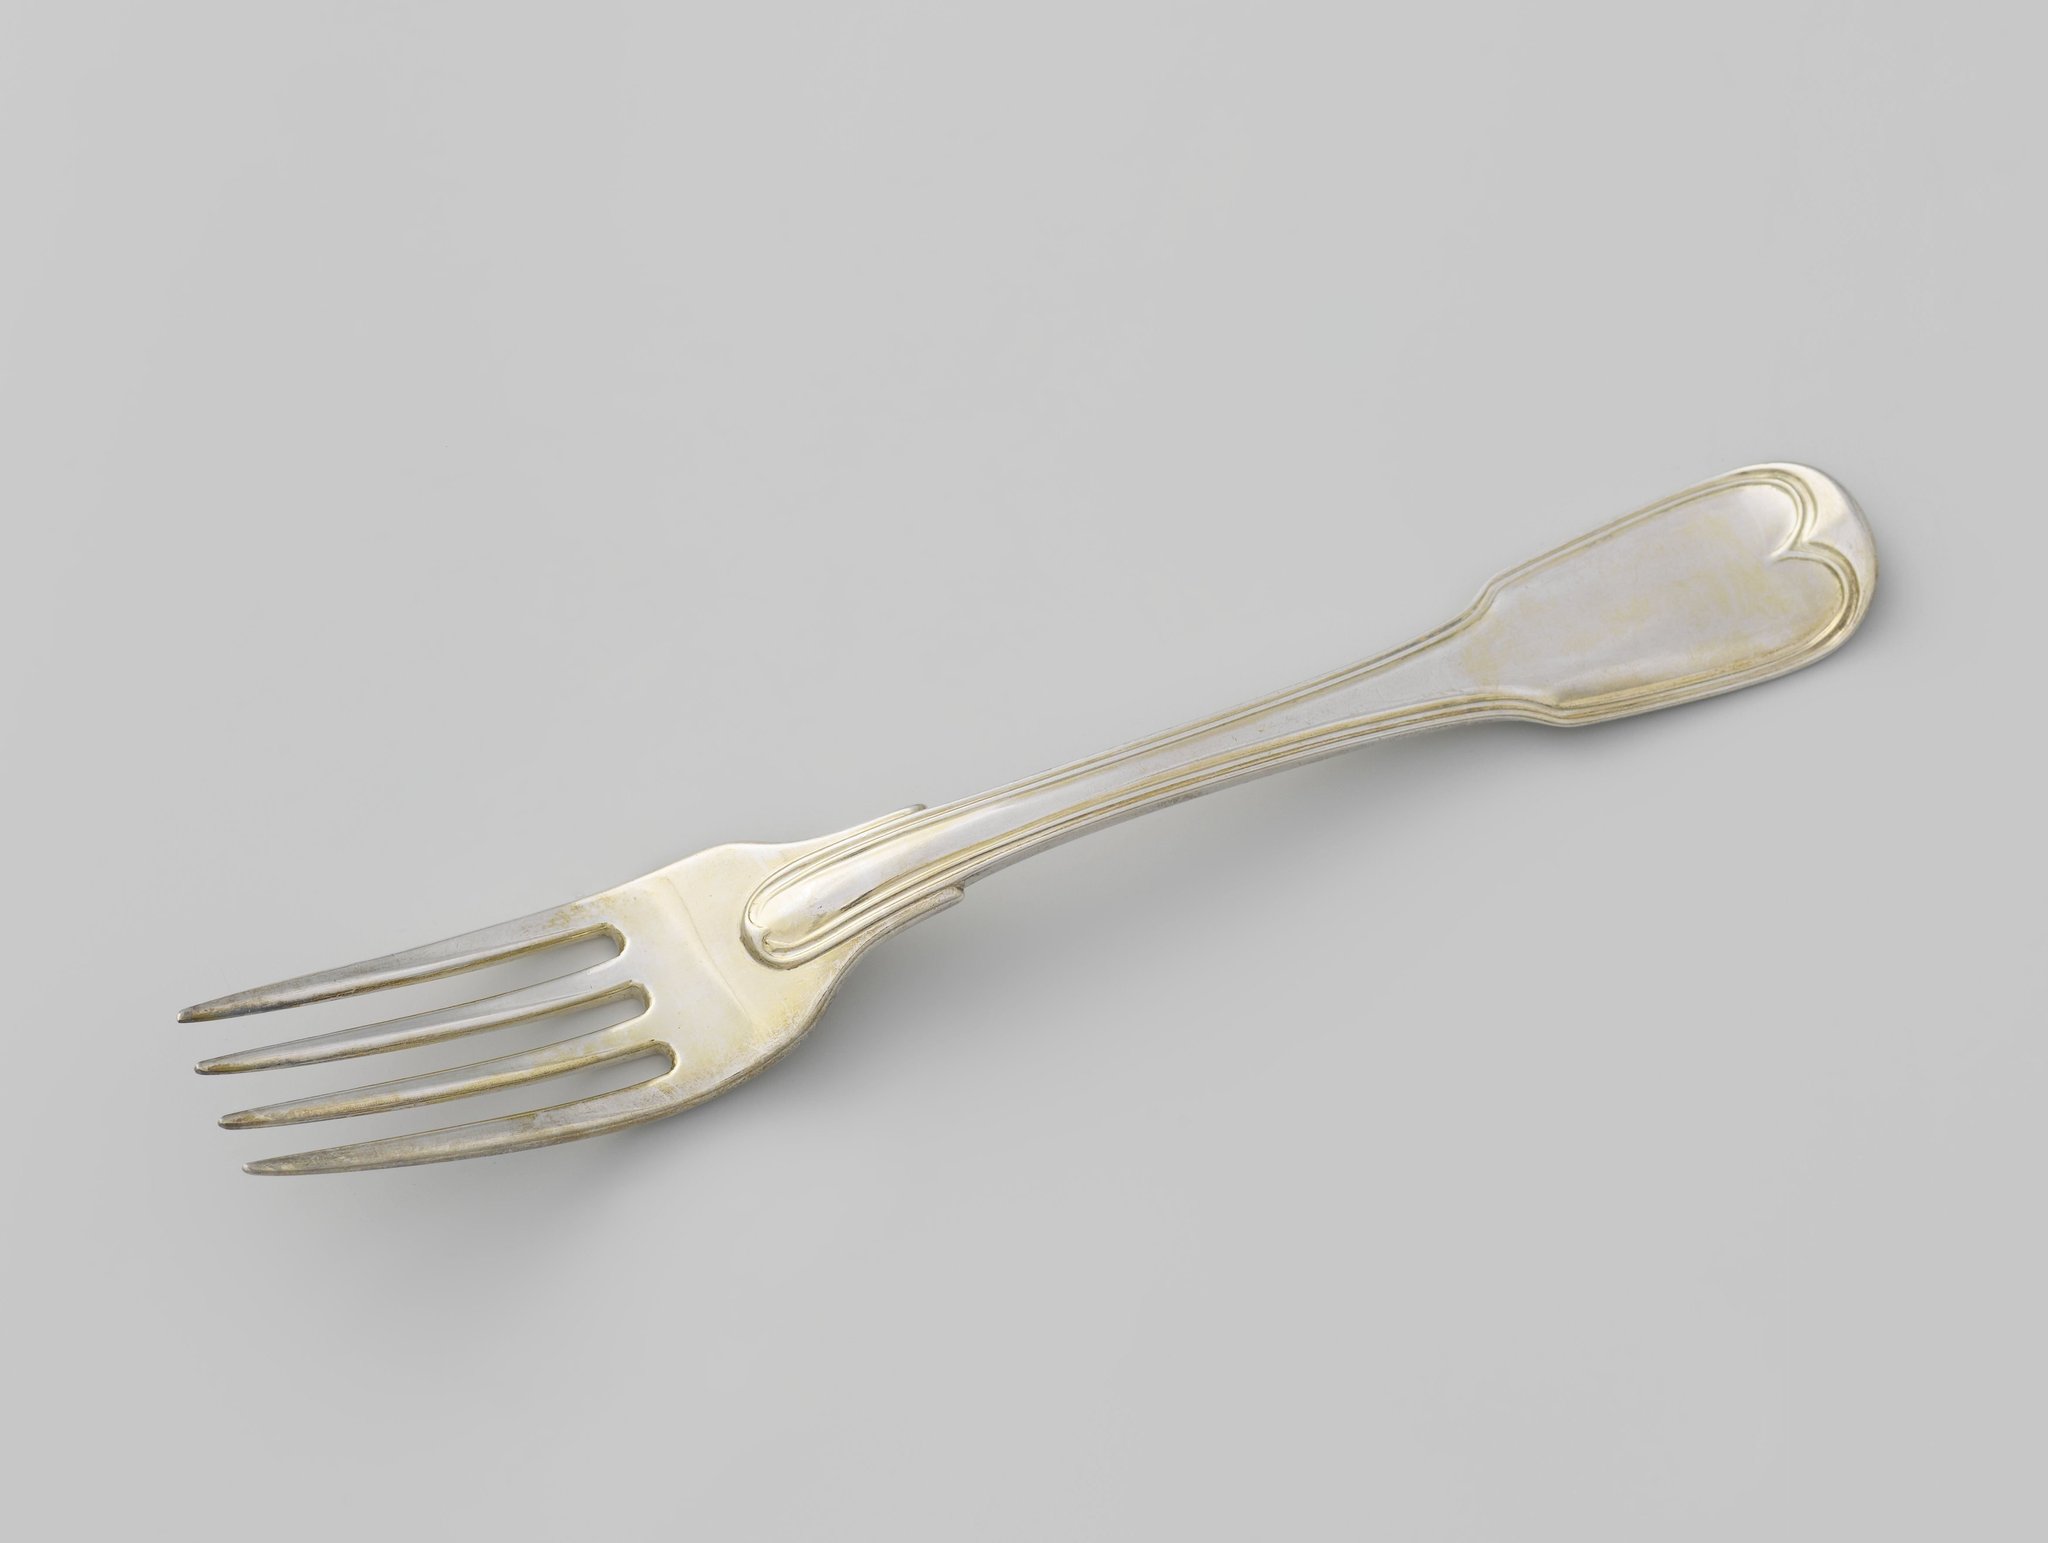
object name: fork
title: Vork met het helmteken Clifford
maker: hendrik helweg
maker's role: silversmith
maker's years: 1802-1858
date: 1832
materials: silver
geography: amsterdam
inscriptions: alloy mark: ‘leeuw 1ste gehalte’, date letter: ‘X (=1806)’, maker's mark: ‘HH onder anker in vierkant’, hallmark: ‘Minervakop met A (keurkamer Amsterdam)’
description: De viertandige vork is aan zowel boven- als onderzijde door middel van enkel lof verbonden met de platte, gebogen steel, die zich verbreedt naar het spatelvormige uiteinde. Boven- en onderzijde van de steel worden omgeven door een dubbele filetrand, die bij het uiteinde ingezwenkt is. Op de onderzijde van de spatel is het helmteken Clifford gegraveerd.